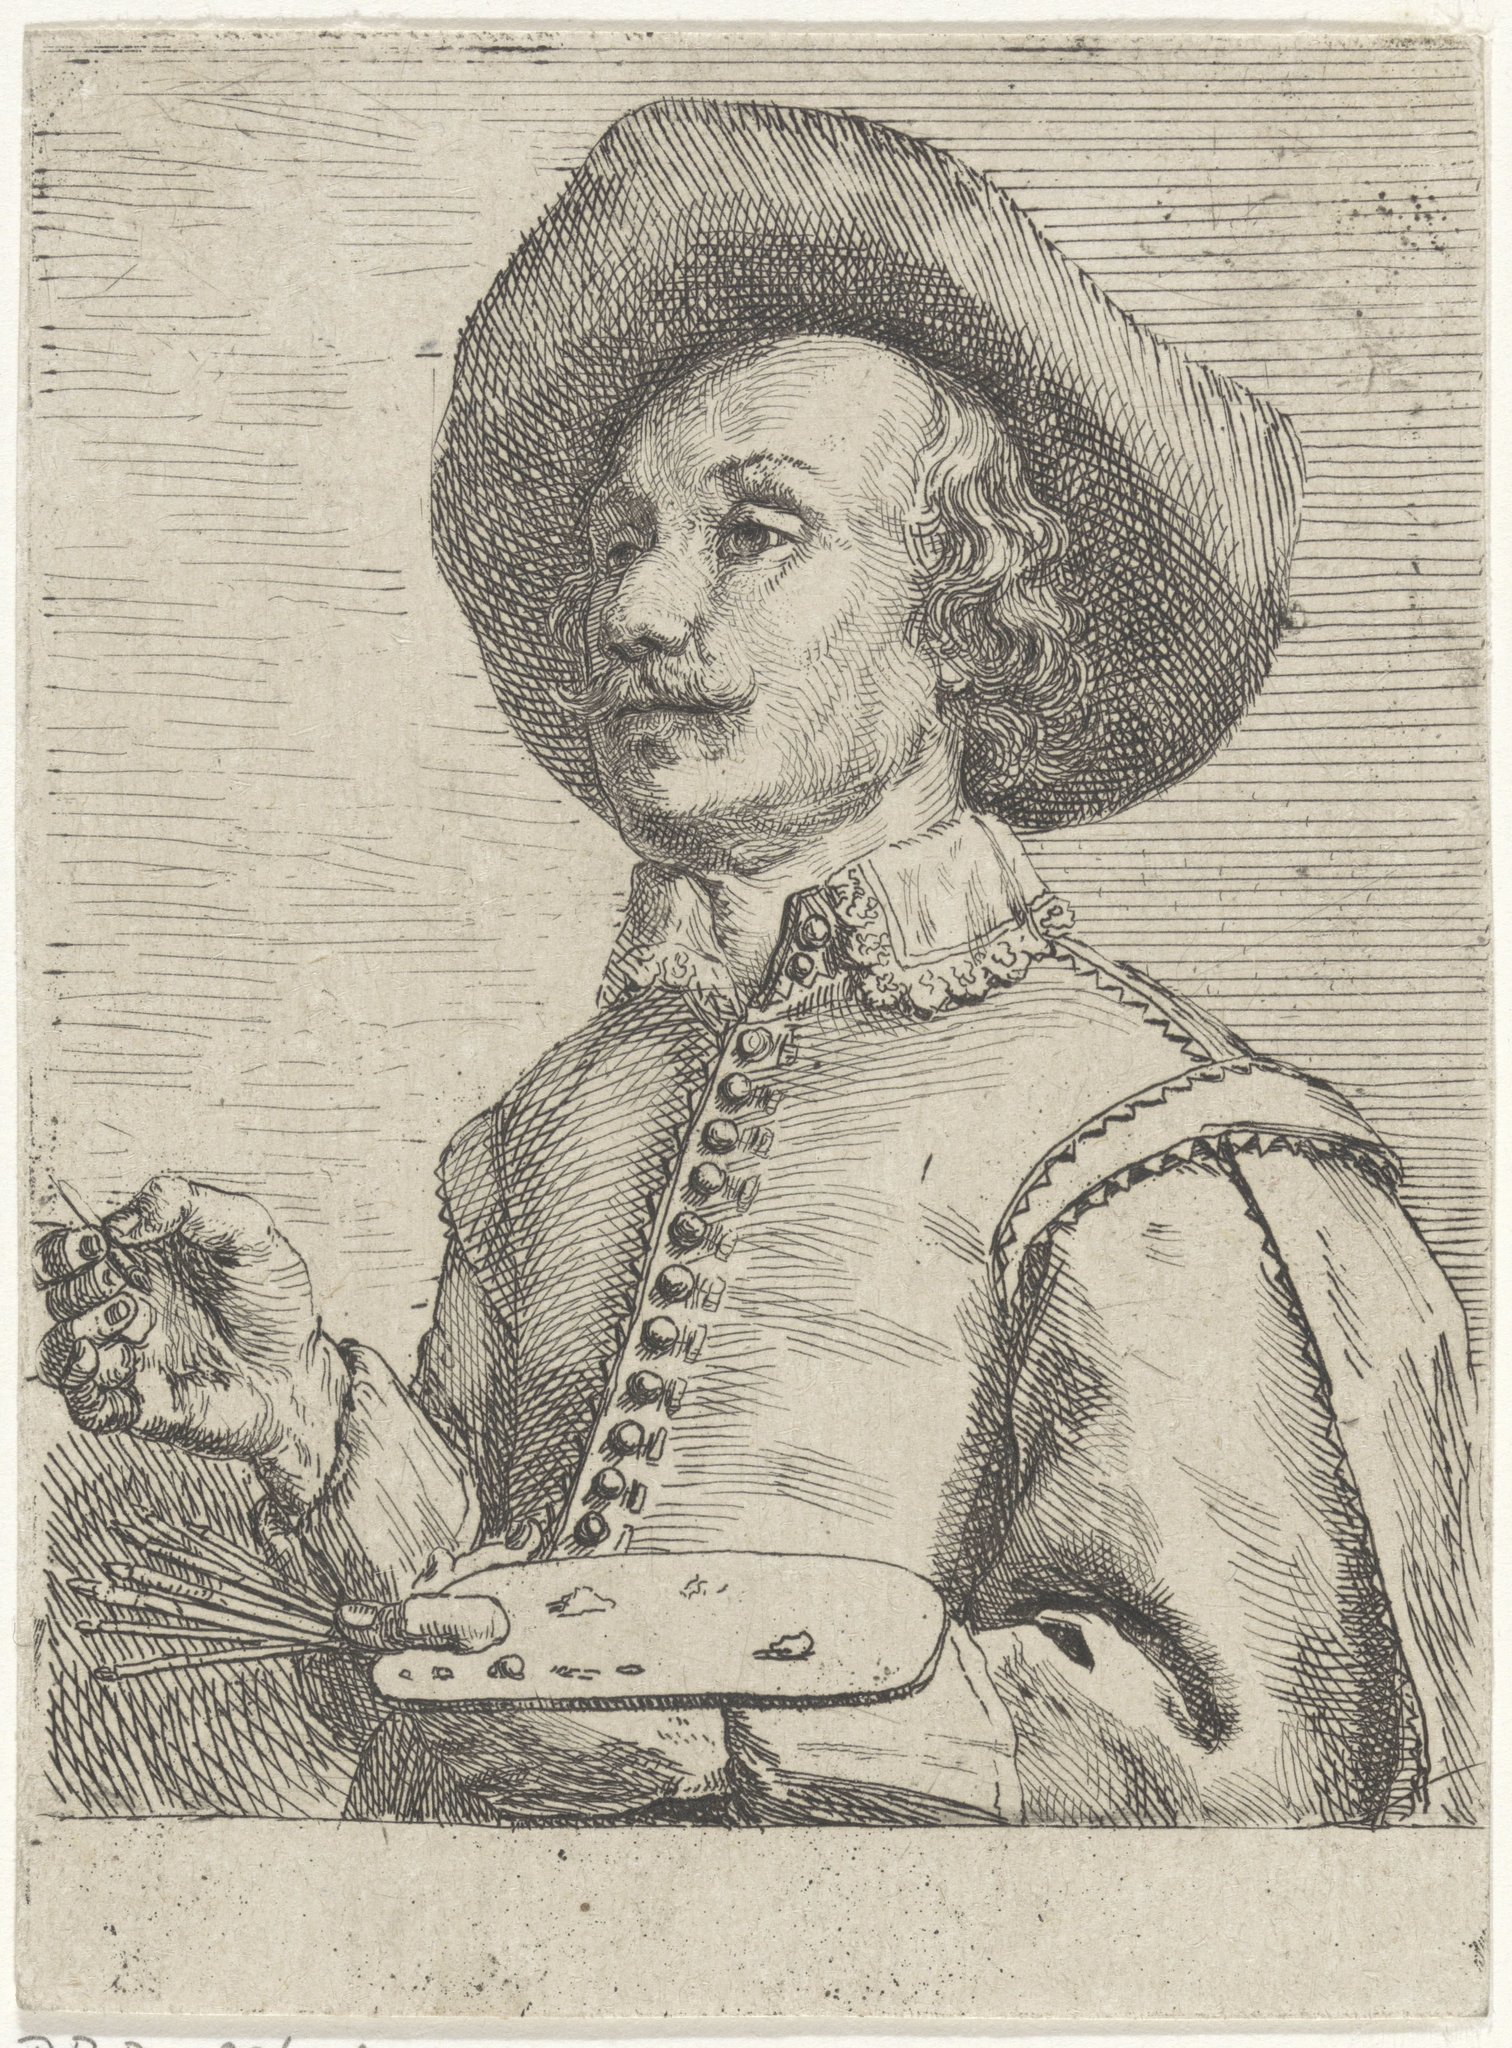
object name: print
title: Zelfportret van Peter Snijers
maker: peeter snijers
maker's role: painter, print maker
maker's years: 1681-1752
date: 1694-1752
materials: paper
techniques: etching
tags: antwerp, painter, print maker, peeter snijers, child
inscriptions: inscription: ‘P. Snayers’, collector's mark: Lugt 2228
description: Zelfportret van de schilder en prentmaker Peter Snijers. Hij houdt een palet en kwasten vast.